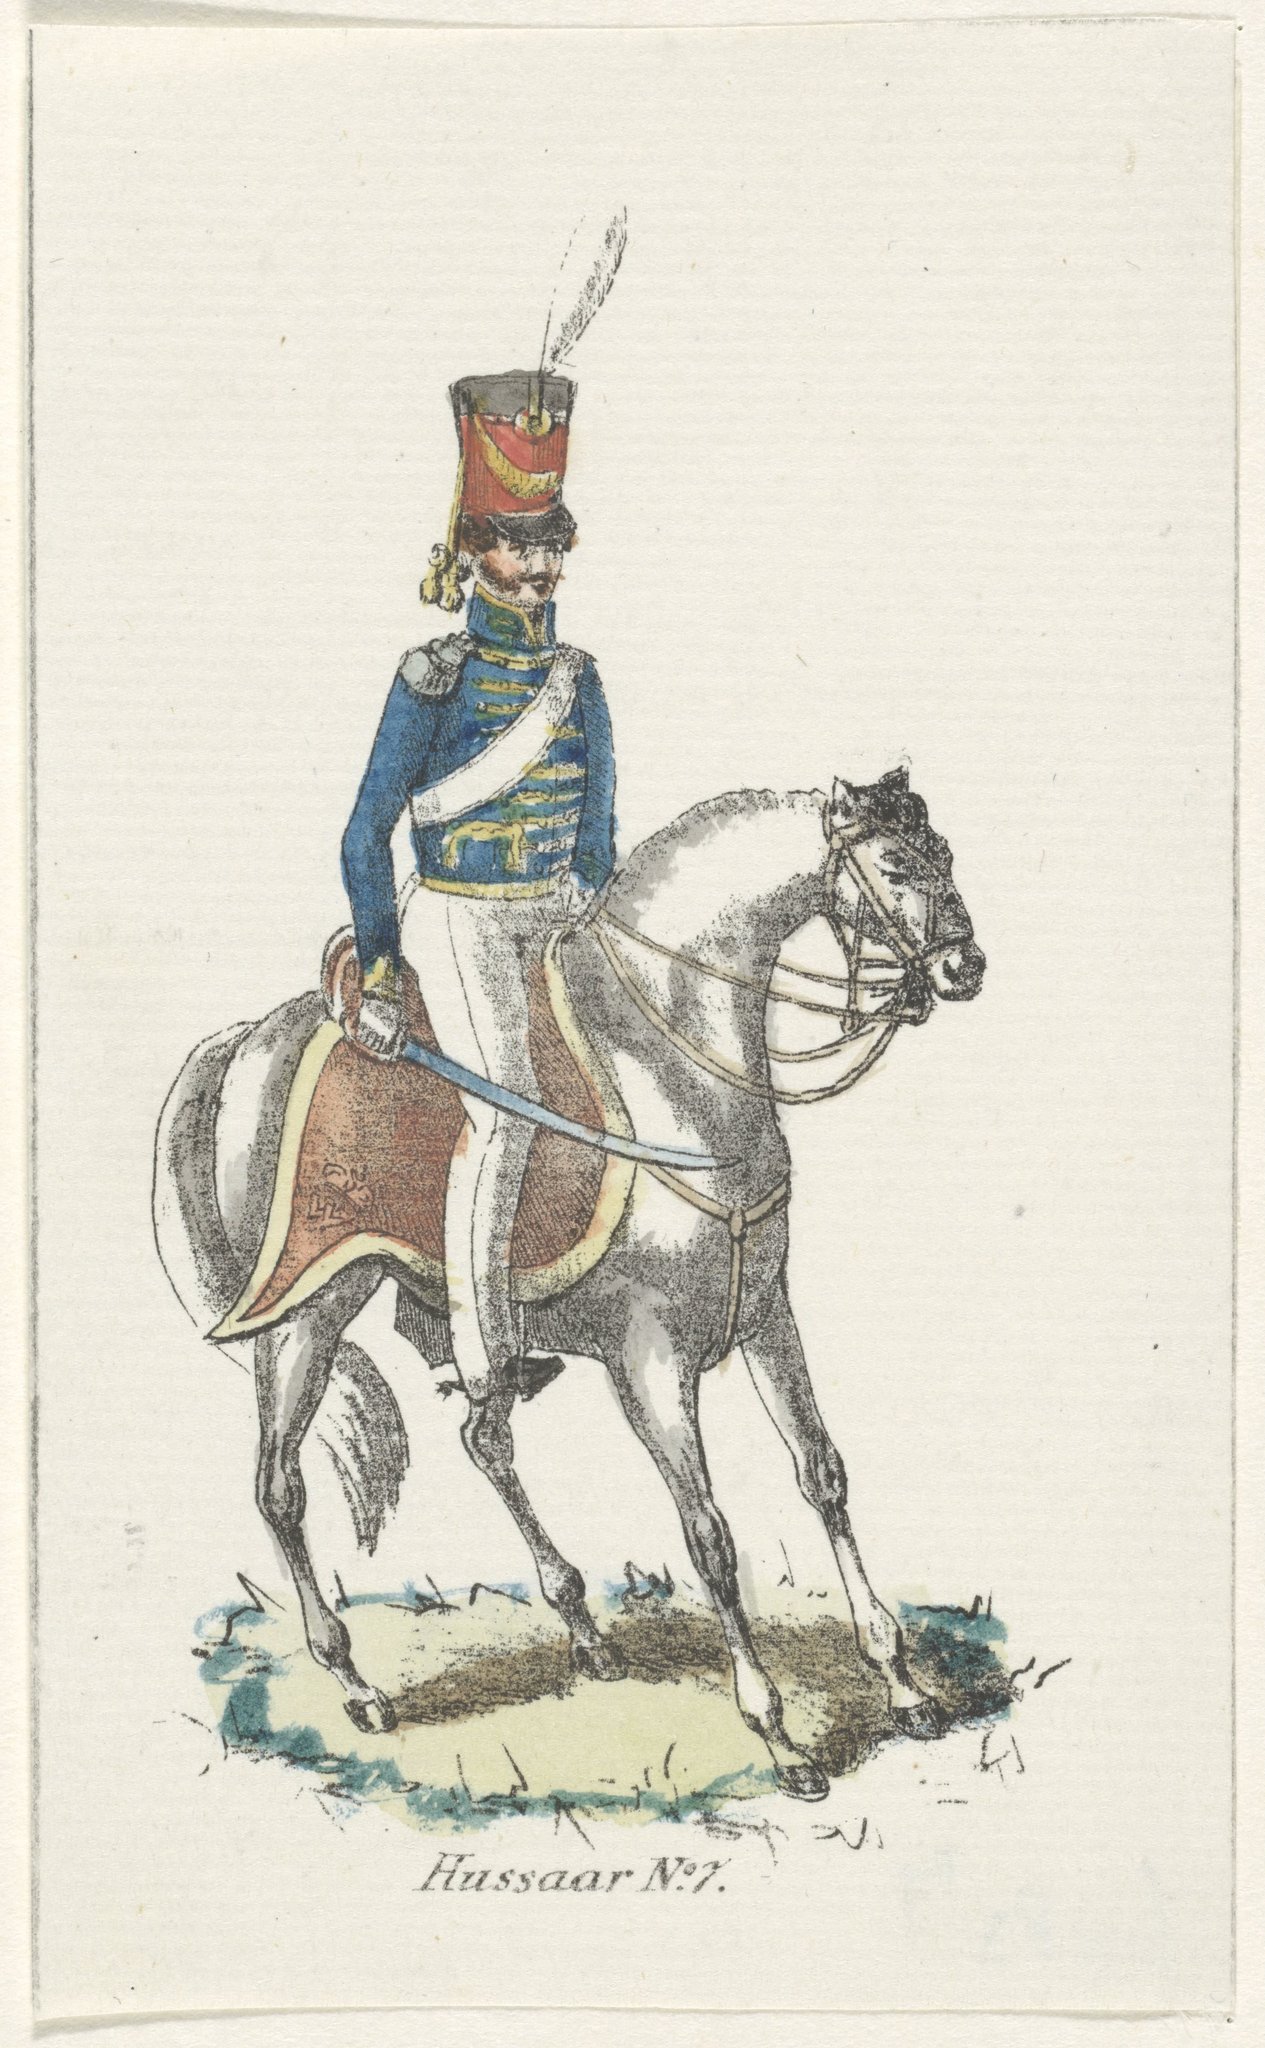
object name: costume print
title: 21 platen van Nederlandse uniformen ca. 1830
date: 1830-1835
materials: paper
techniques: hand coloring, lithograph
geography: amsterdam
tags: (military) uniforms, clothes, costume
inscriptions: collector's mark: Lugt 2228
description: Verkleinde kopieën naar de prenten van Houtman e.a. in FMH 6481. Muller beschrijft een onversneden compleet blad in de collectie Van Gijn waarop de namen van de prentmaker en de uitgever vermeld staan.